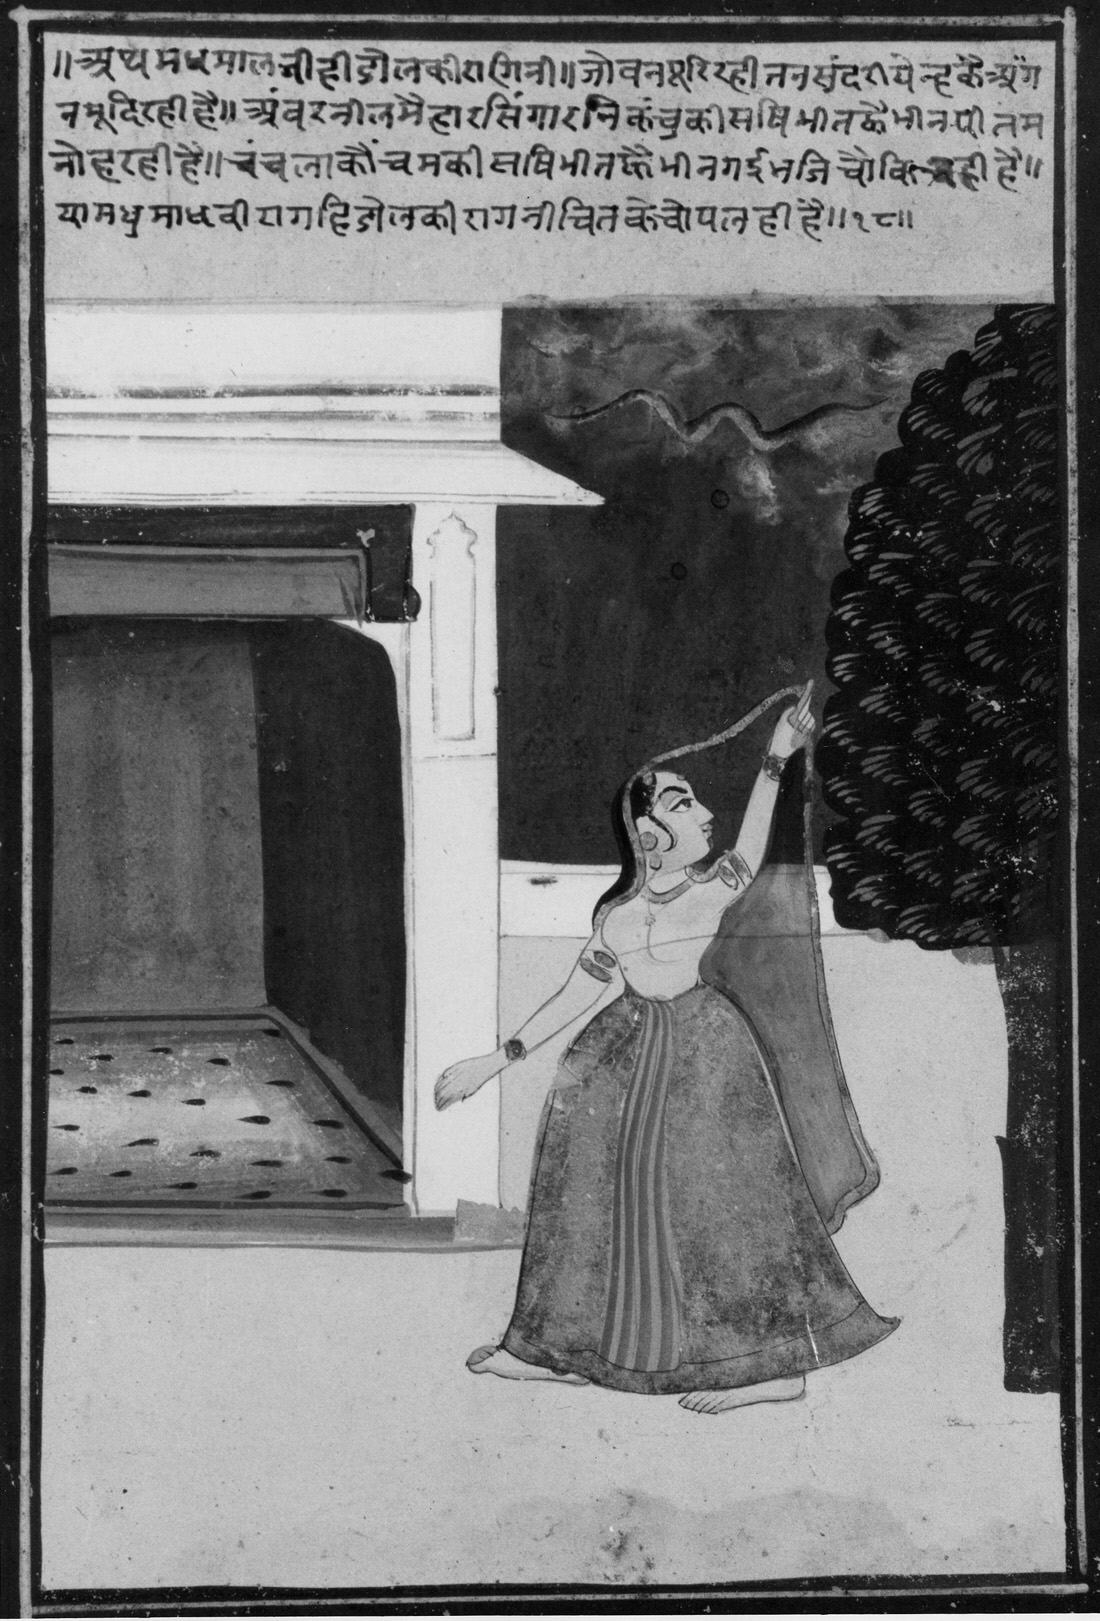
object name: leaf from a ragamala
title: Maiden Dancing Before a Storm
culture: indian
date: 1867-1933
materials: gold, paper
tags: women,dancing